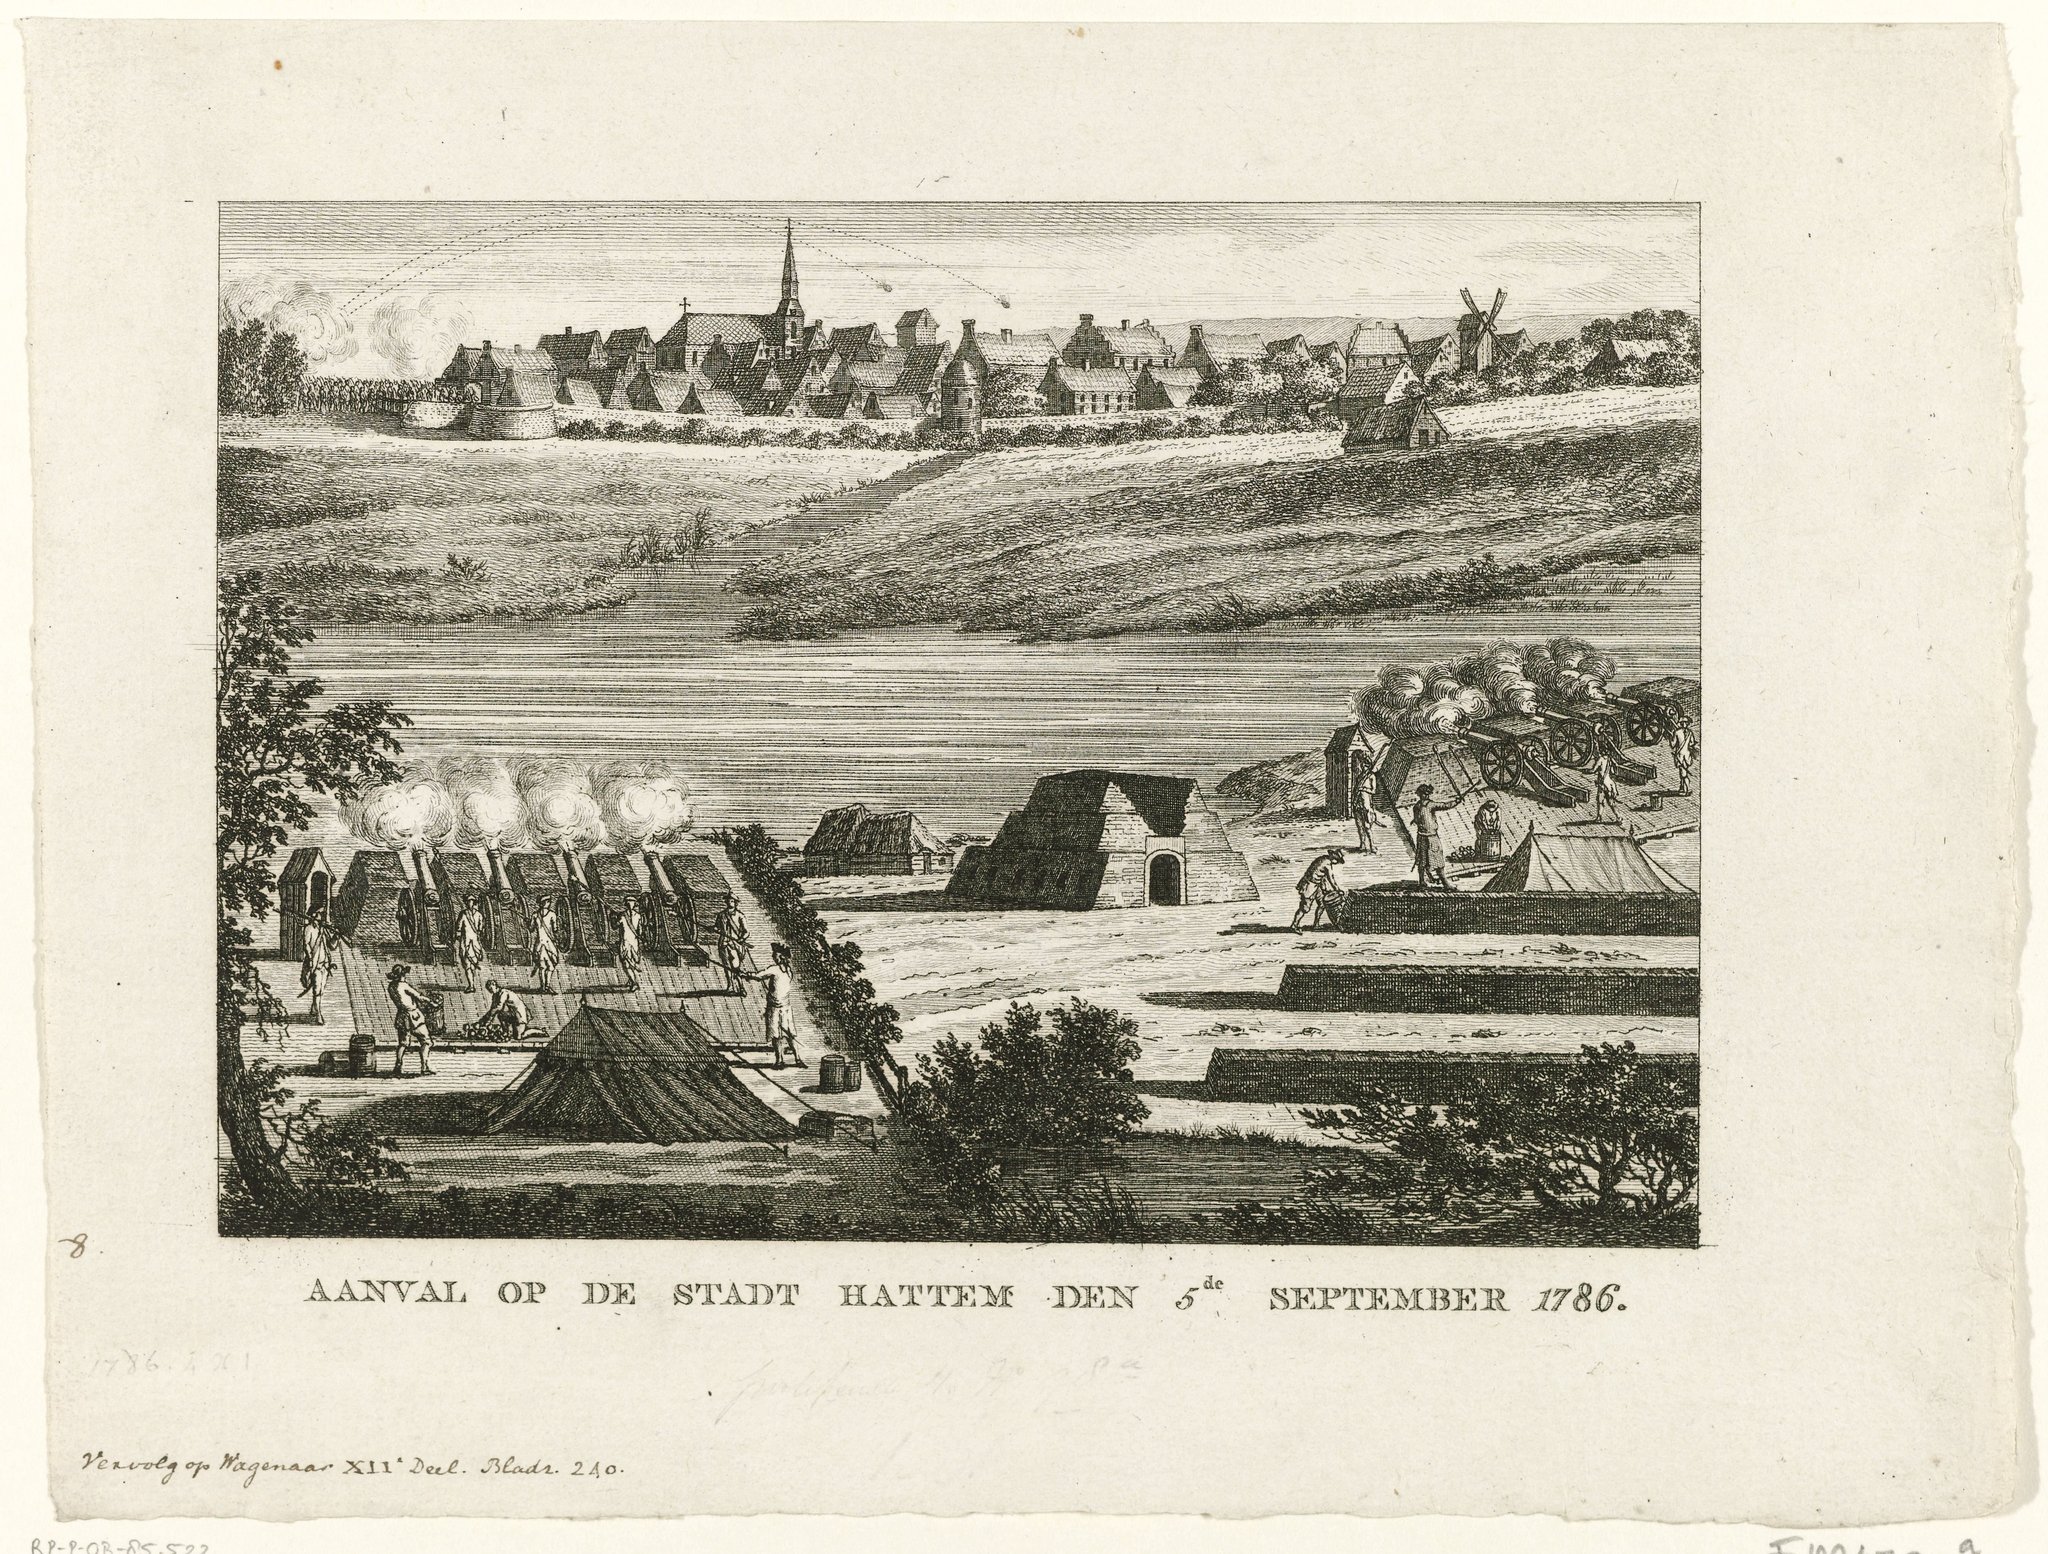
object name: print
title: Aanval op Hattem, 1786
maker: Anonymous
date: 1786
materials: paper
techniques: engraving, etching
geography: northern netherlands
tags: bombardment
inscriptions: collector's mark: Lugt 2228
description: Beschieting van de stad Hattem door de stadhouderlijke troepen, 5 september 1786.